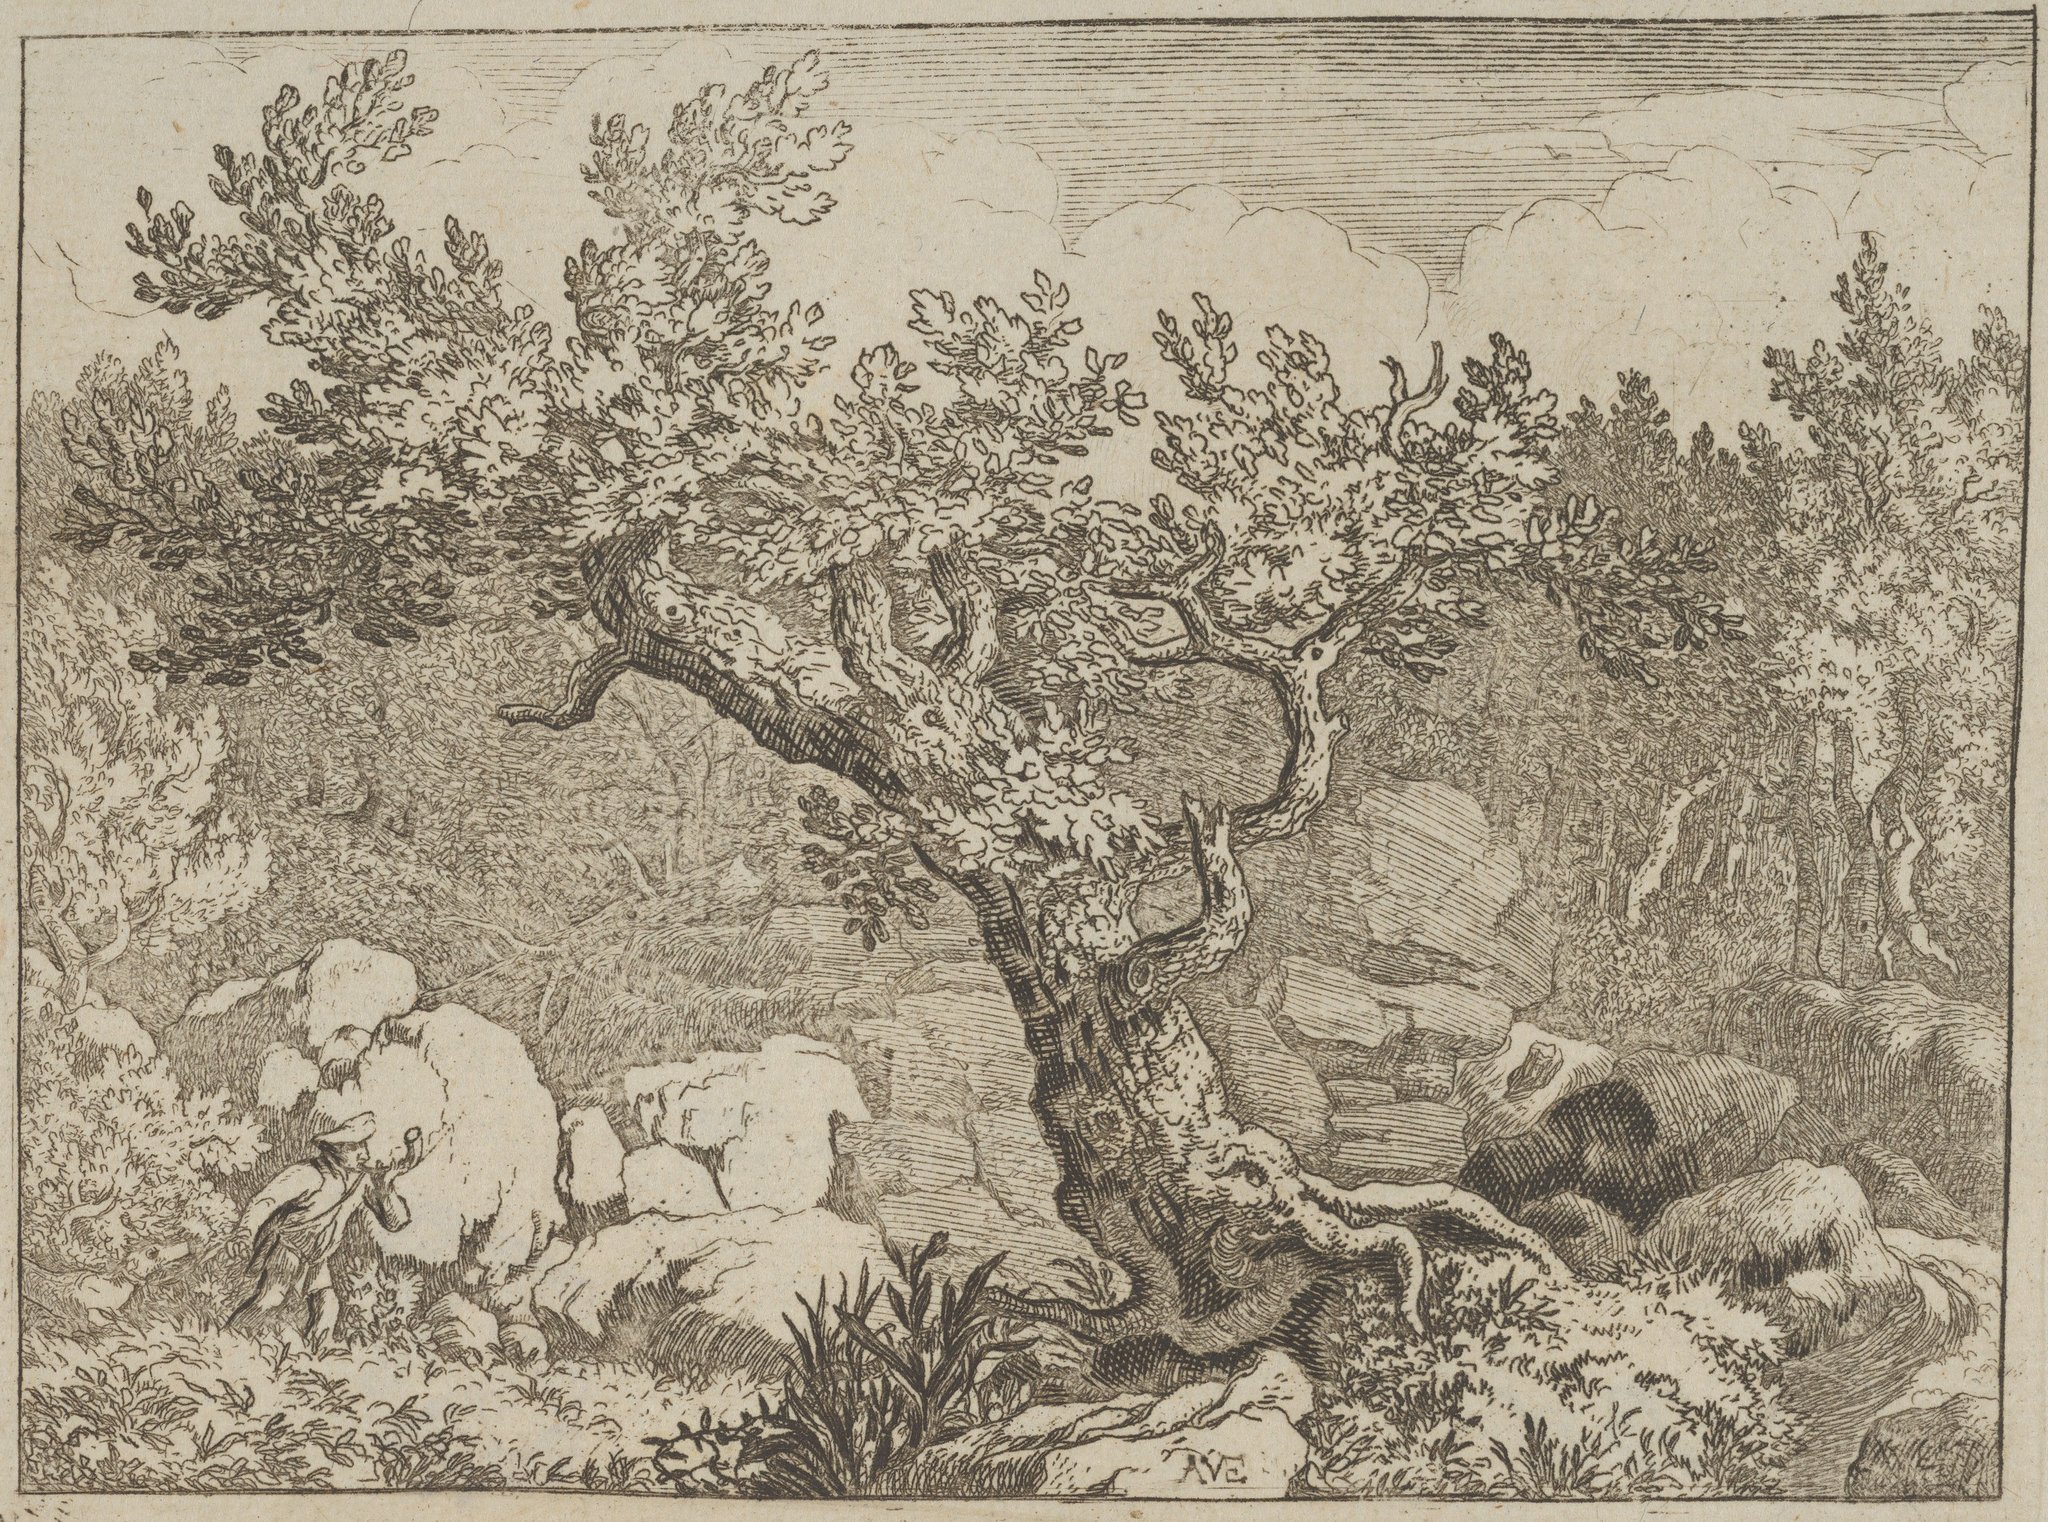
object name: print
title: The Sportsman near the Large Tree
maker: allart van everdingen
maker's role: artist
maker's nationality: dutch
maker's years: 1621-1675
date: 1621-1675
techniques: engraving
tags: men,trees